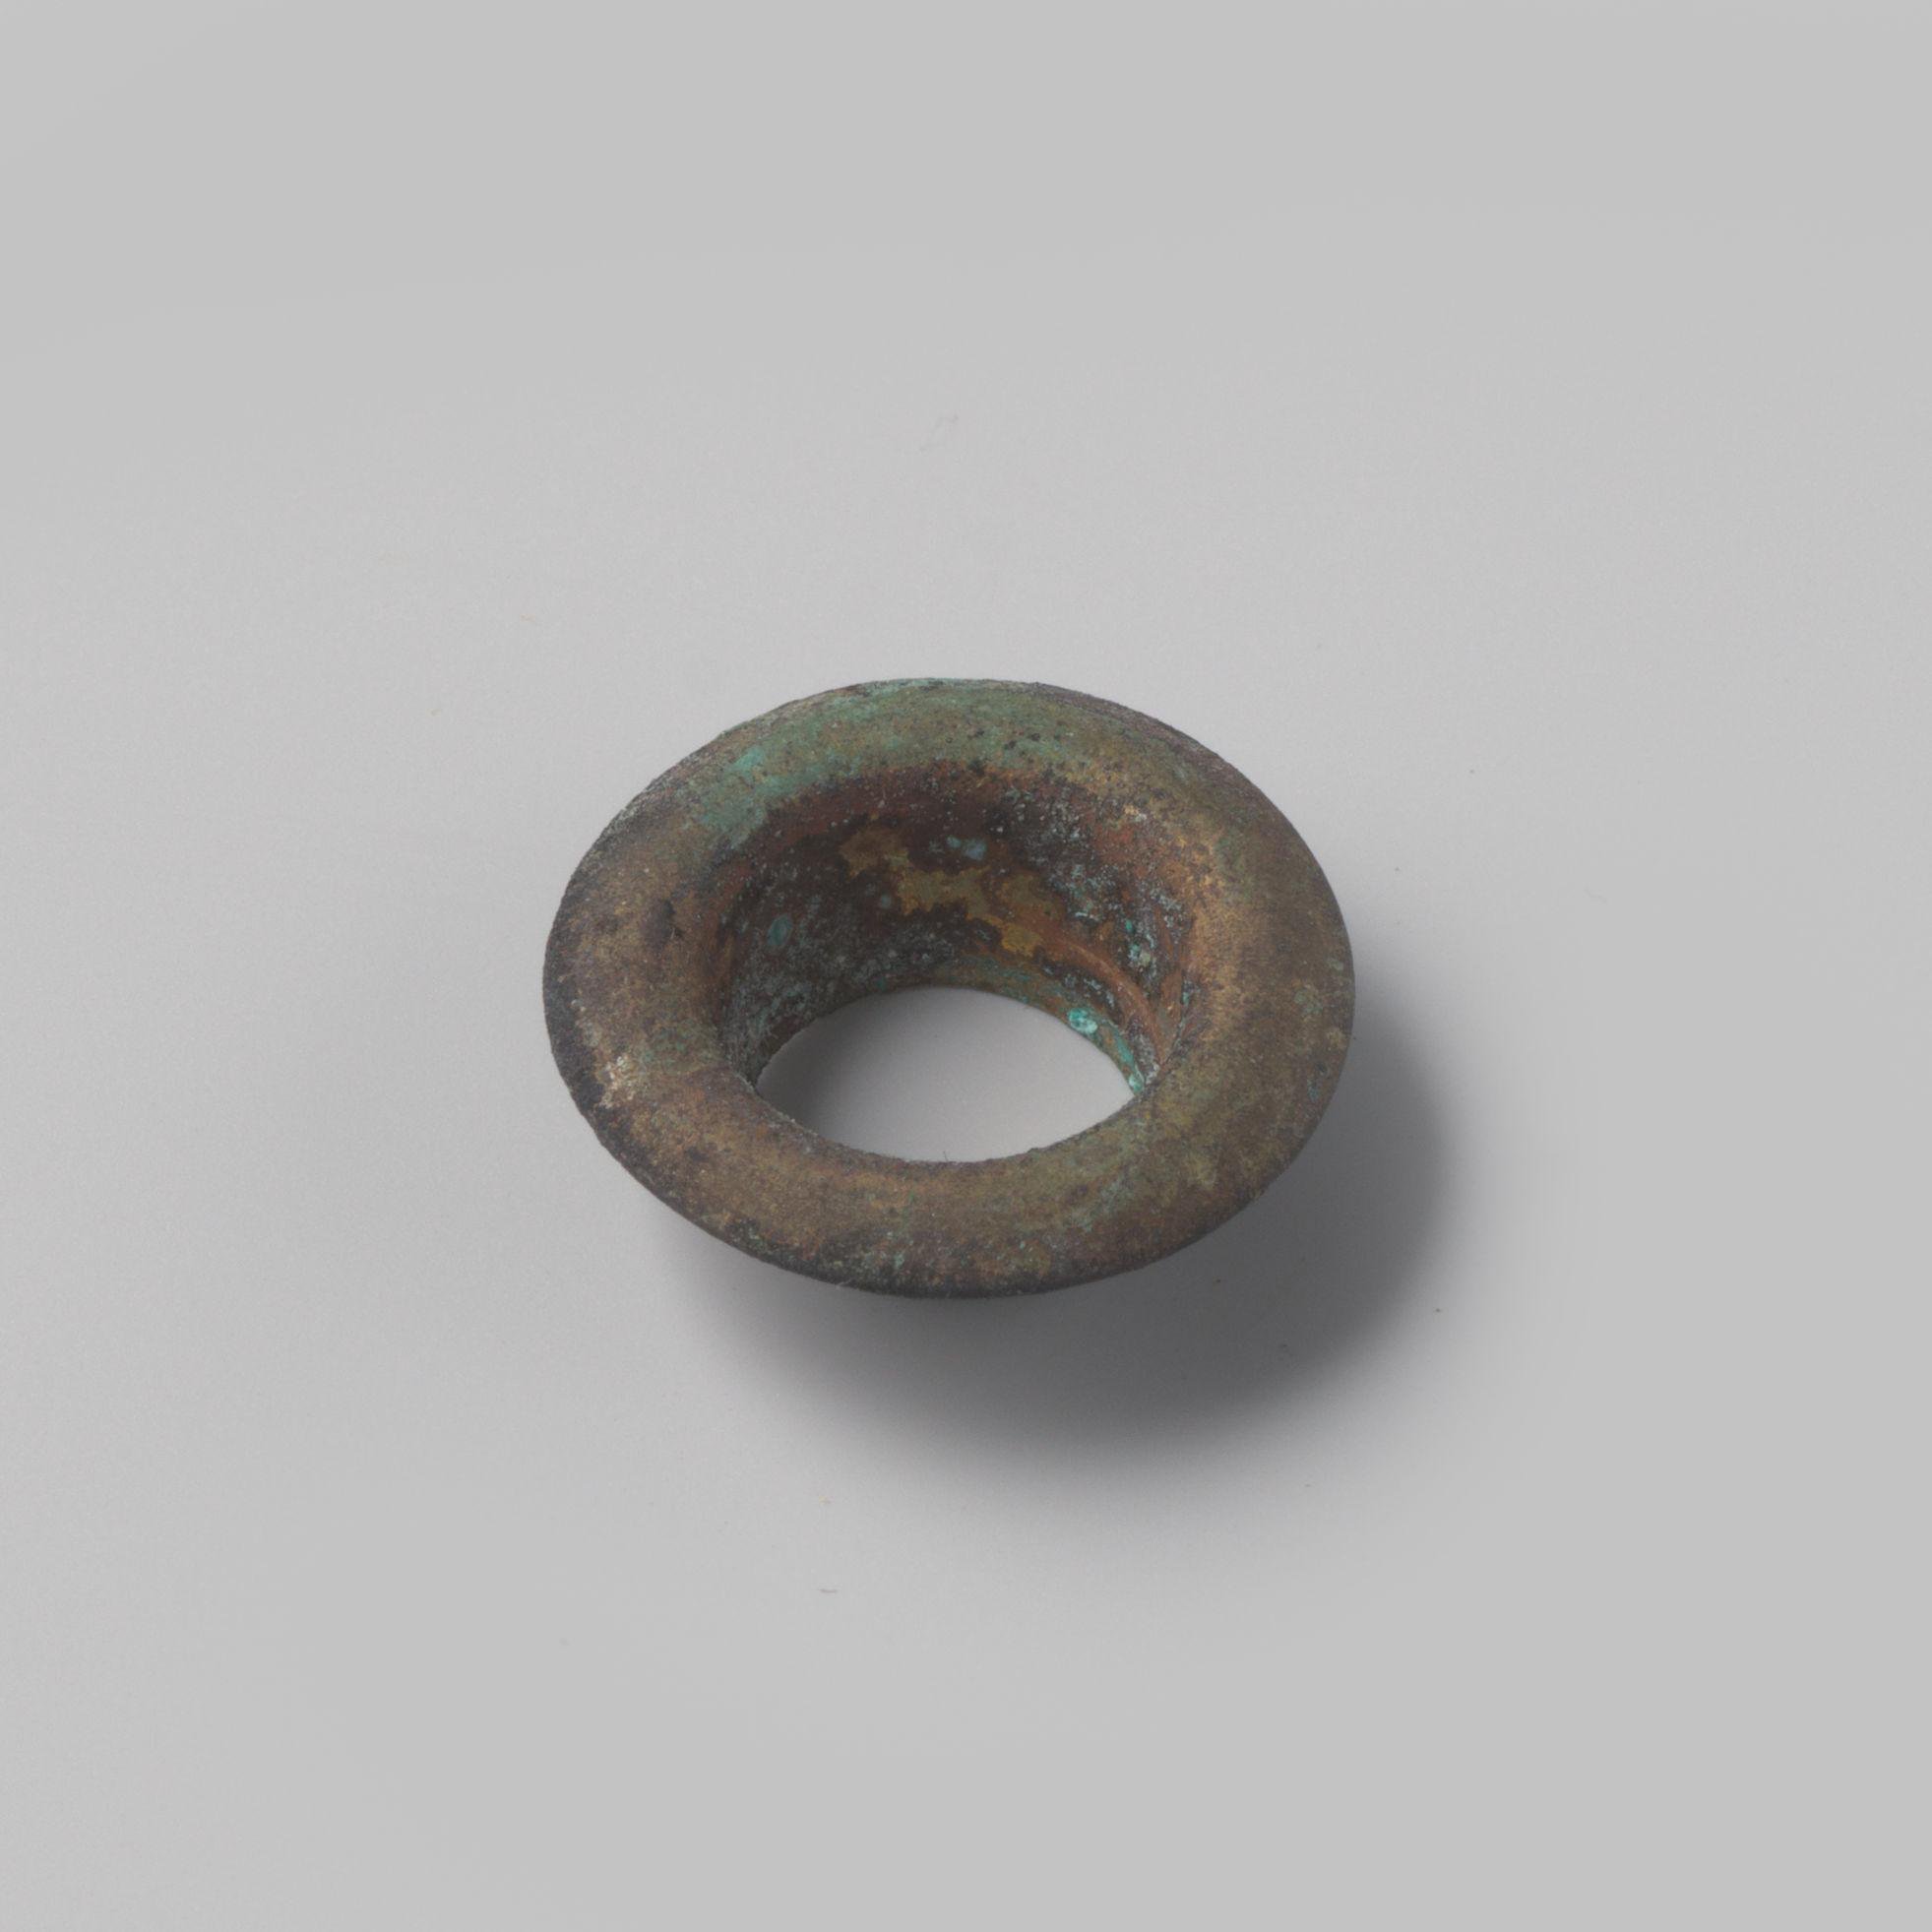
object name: ring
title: Koperen ring uit het wrak van de Oostindiëvaarder Hollandia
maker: Anonymous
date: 1700-1743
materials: copper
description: Koperen ring met opstaande rand, wellicht onderdeel geweest van lederen object.